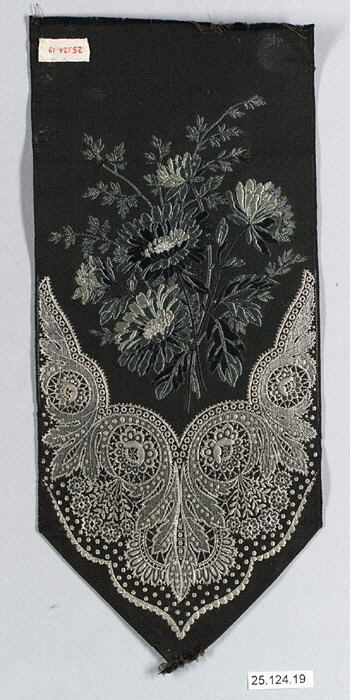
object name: necktie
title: Woman's necktie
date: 1870-1880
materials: silk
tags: flowers